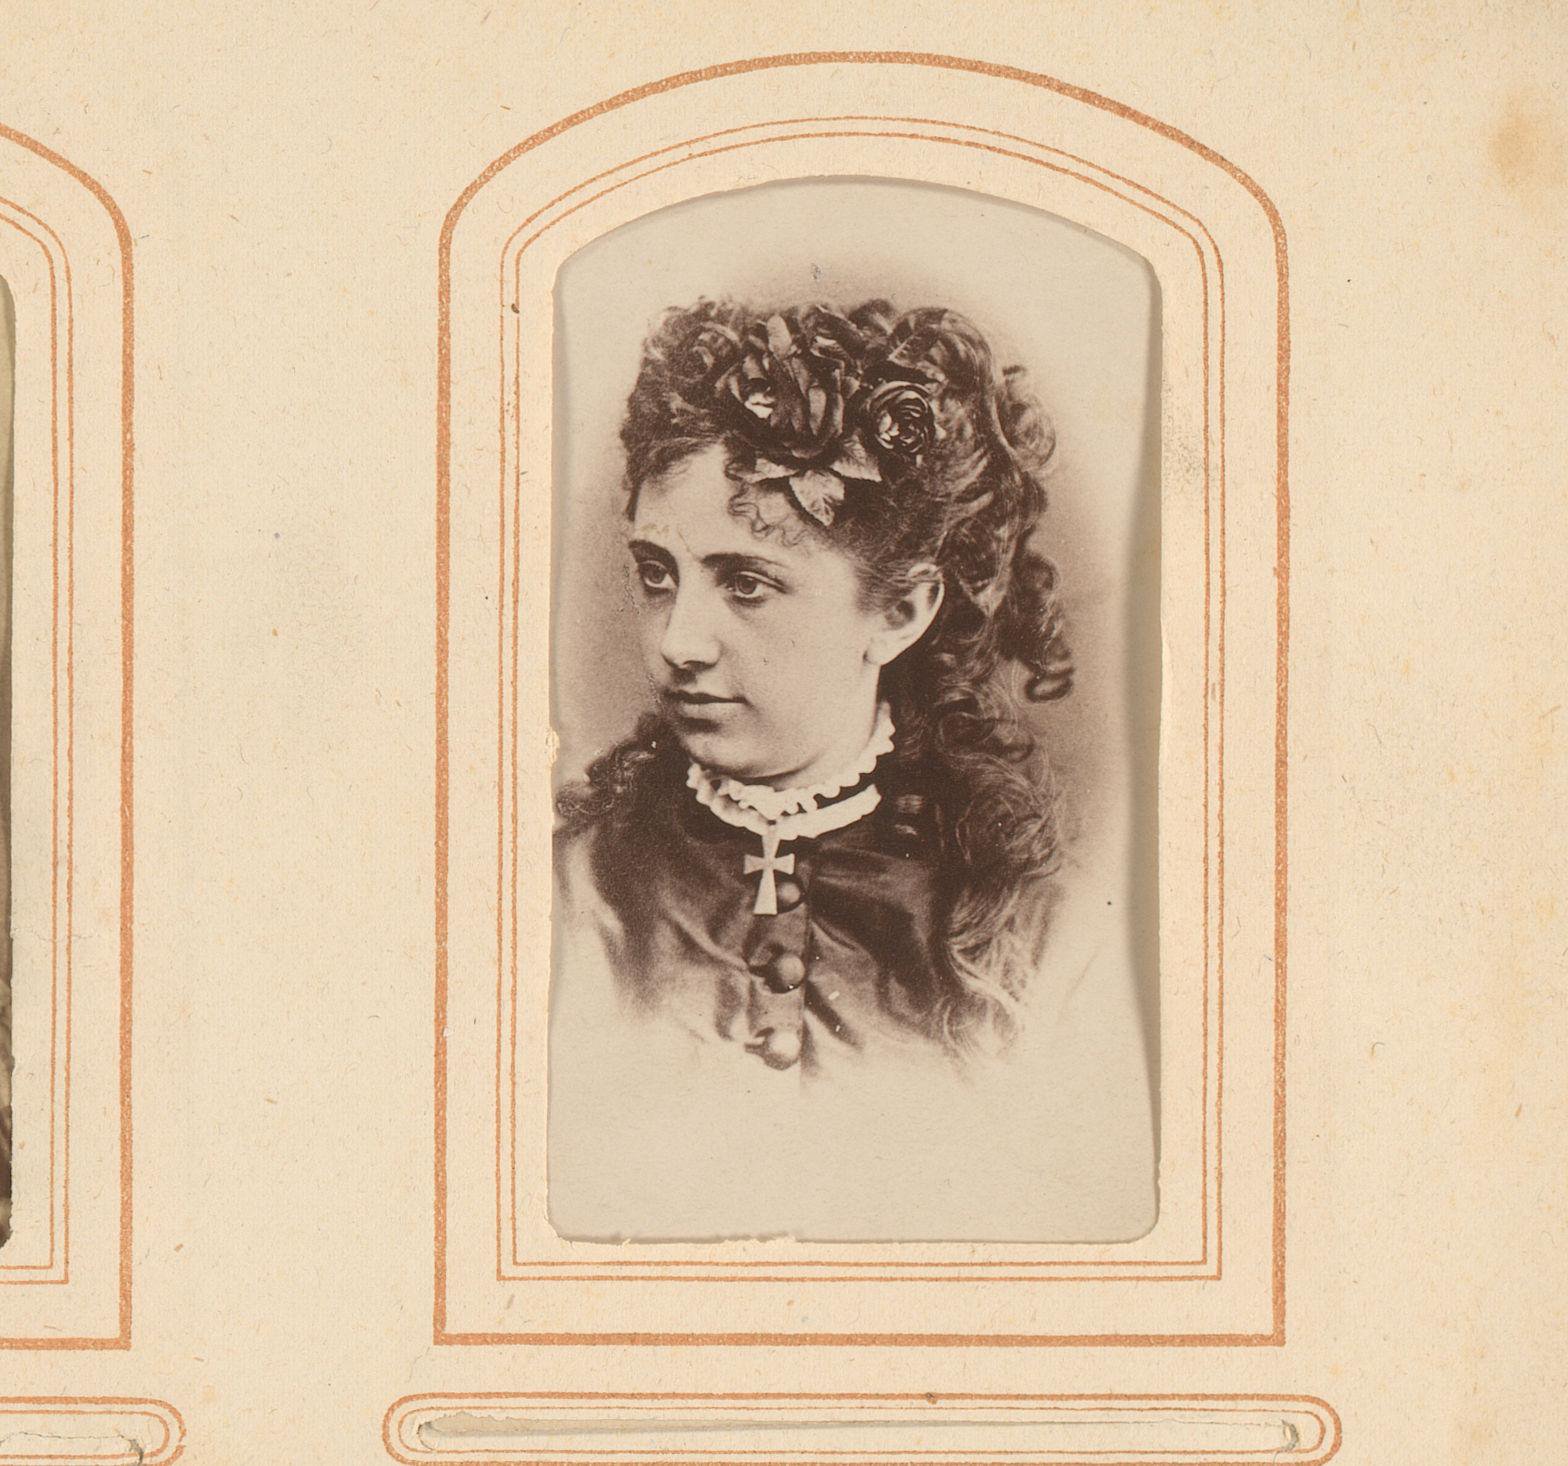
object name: photograph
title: Portret van een vrouw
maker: Anonymous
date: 1855-1890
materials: cardboard, photographic support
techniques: albumen print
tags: adult woman, historical persons, necklace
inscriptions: annotation: ‘Fr[...] Björklund/ [...]/ (nu Fru Bo[...])’